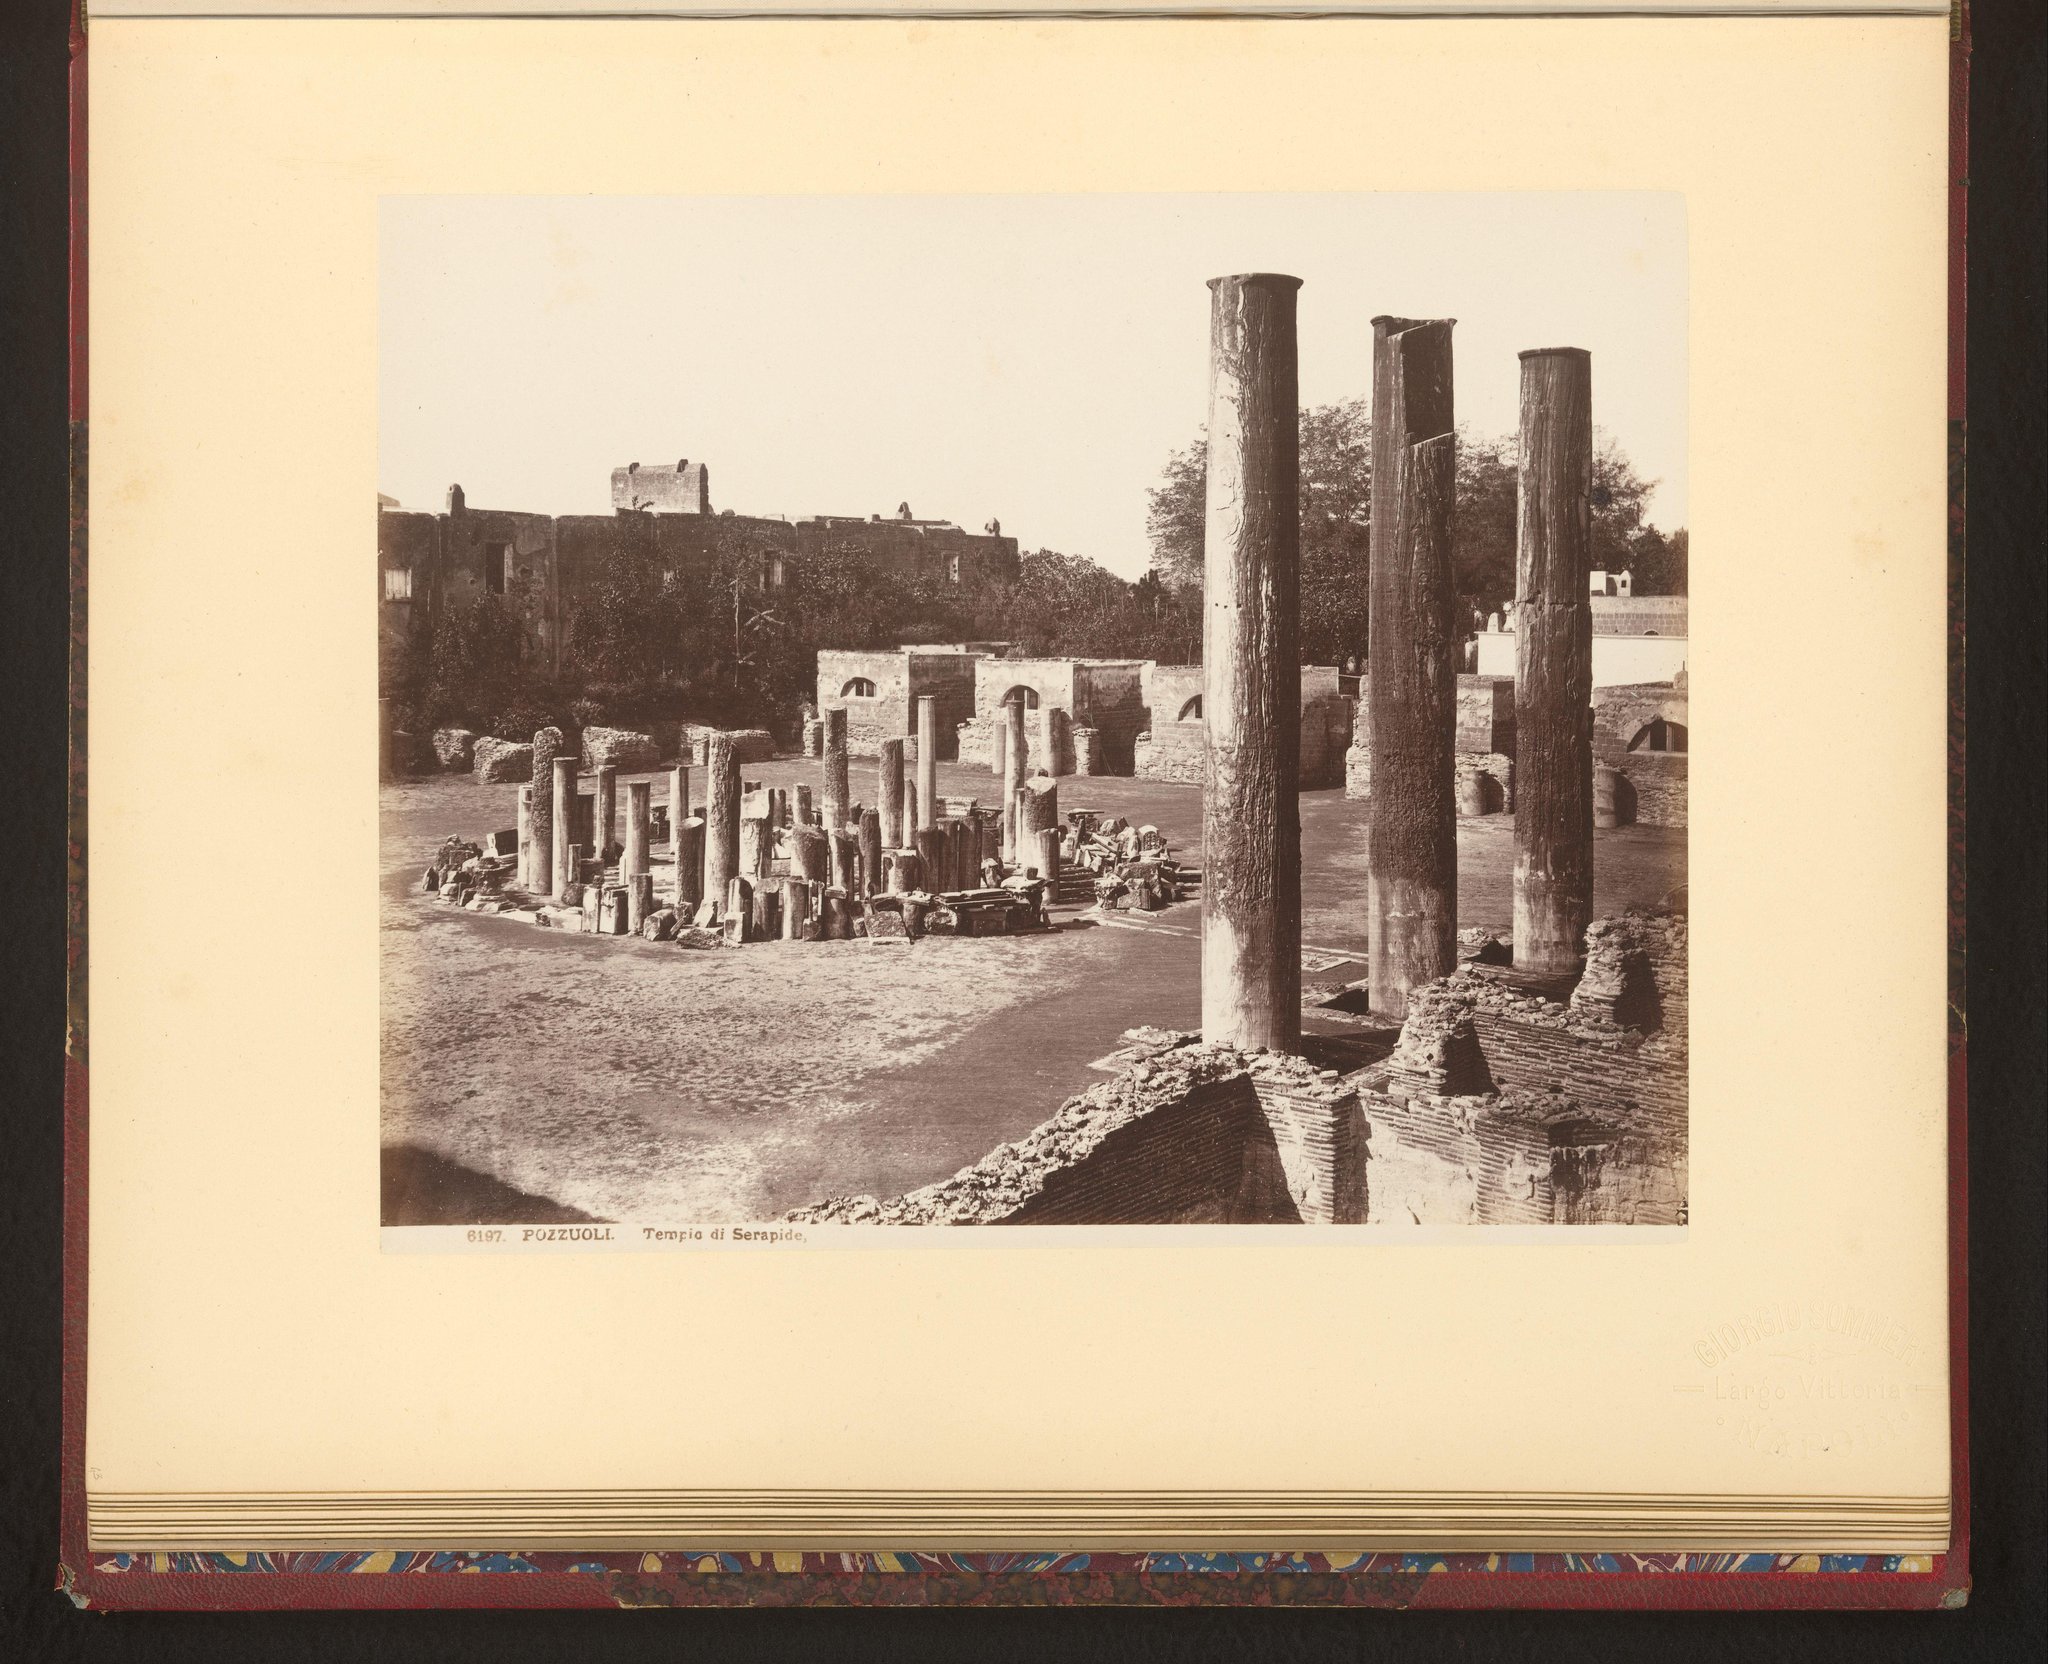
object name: album leaf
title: Pozzouli, Tempio di Serapide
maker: giorgio sommer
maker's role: fotograaf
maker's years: 1834-1914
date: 1874-1879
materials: photographic support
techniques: albumen print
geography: pozzuoli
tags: column, pillar ~ architecture, ruin of a building ~ architecture, market-hall, pozzuoli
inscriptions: number: ‘6197’, workshop stamp: ‘Giorgio Sommer/ Largo Vittoria/ Napoli’